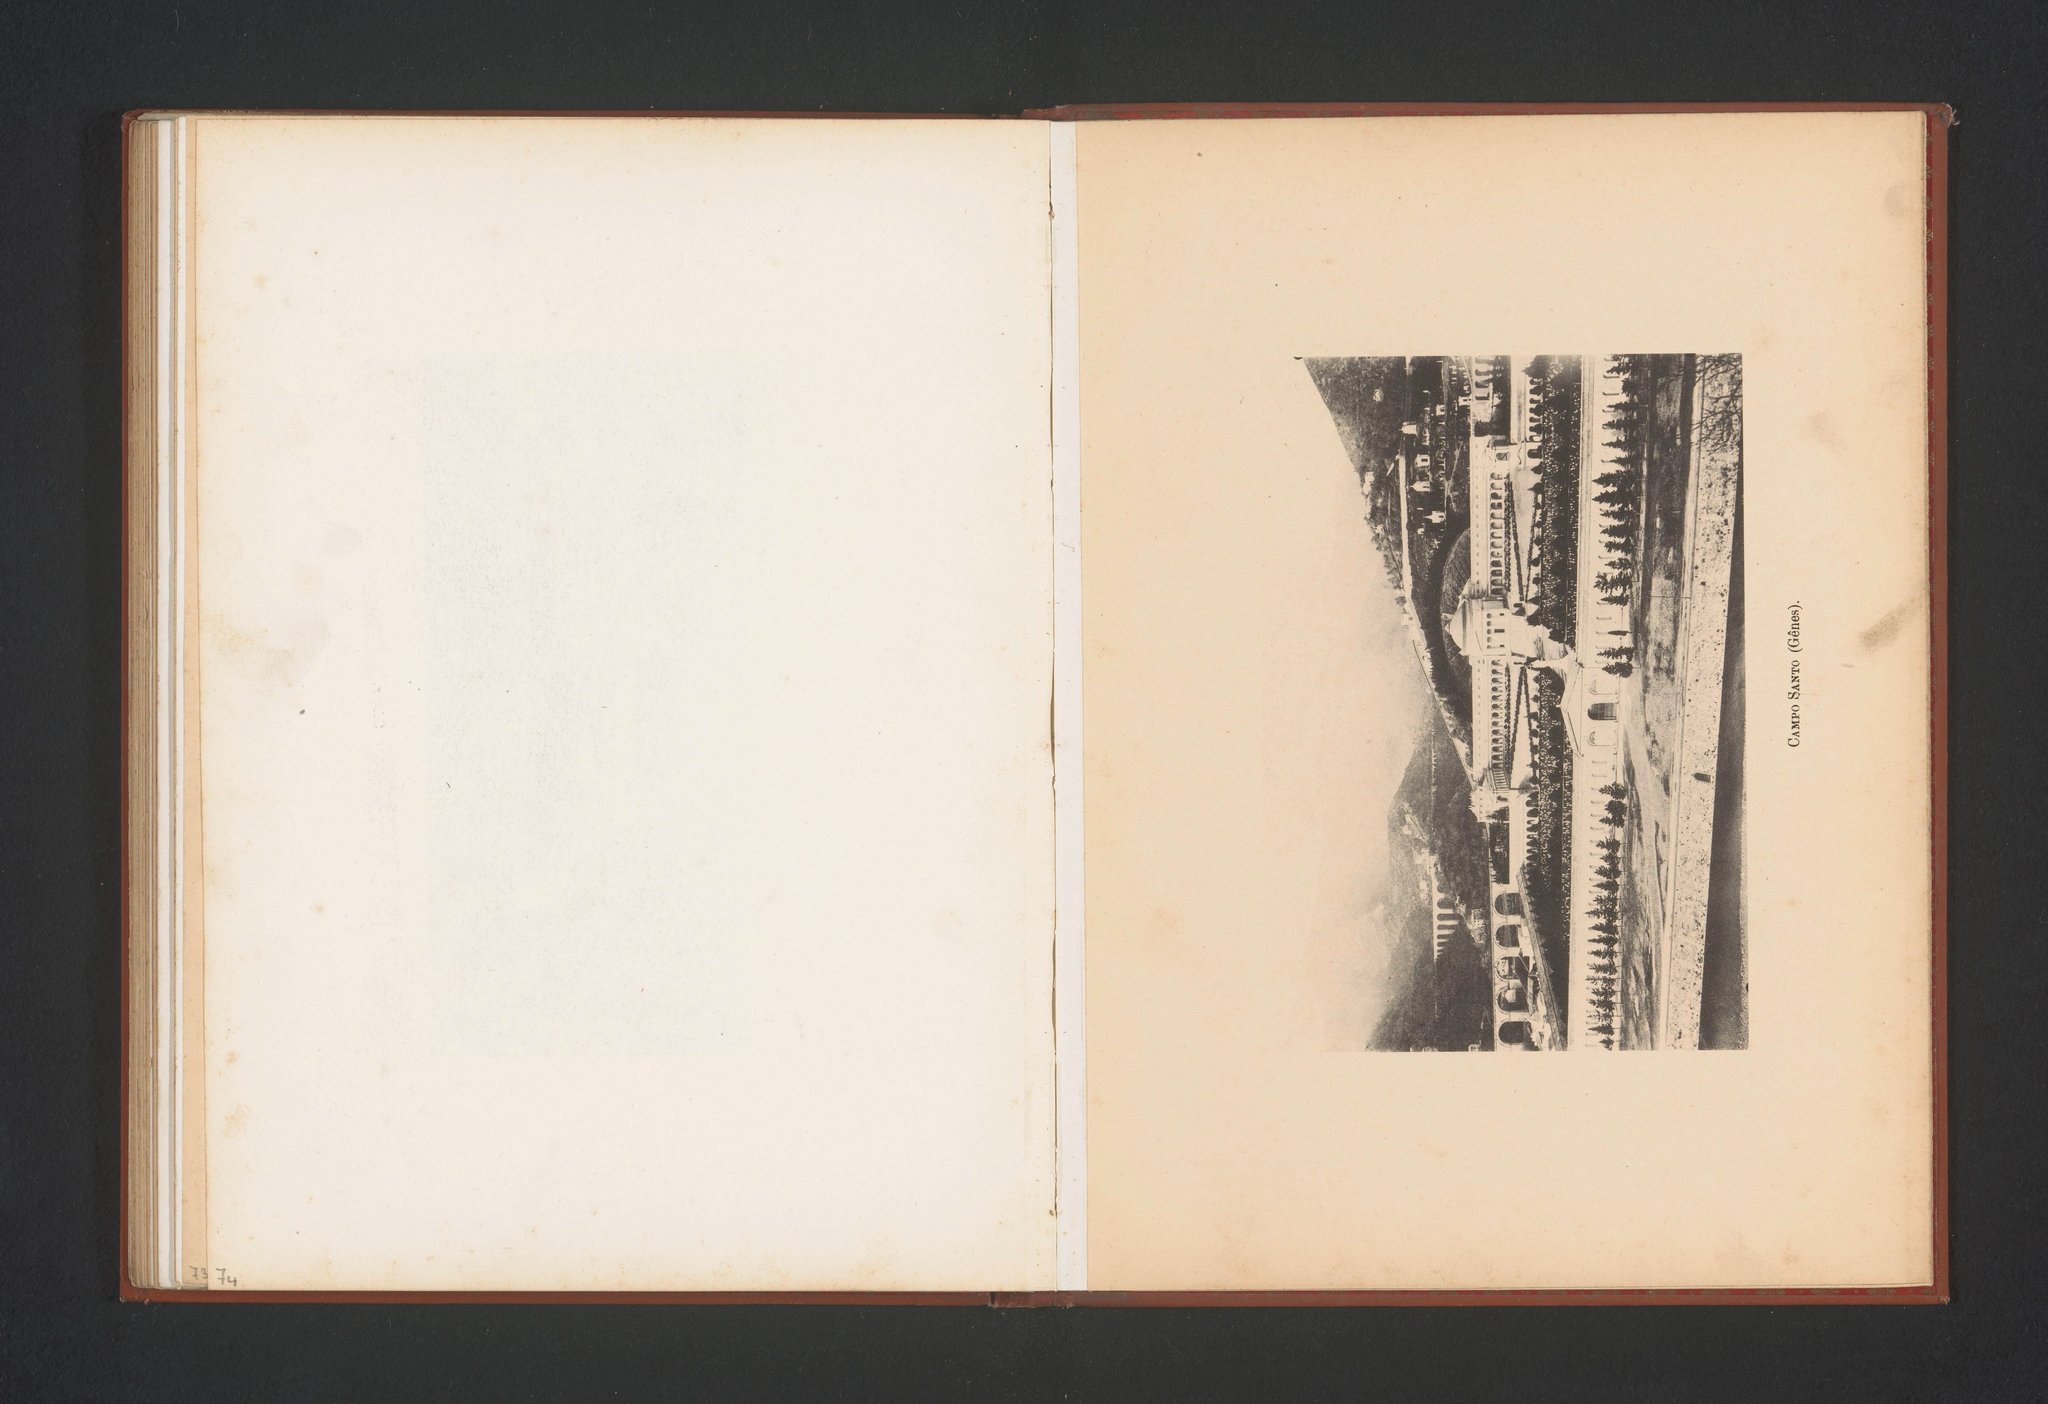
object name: page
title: Gezicht op de begraafplaats Campo Santo in Genua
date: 1880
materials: paper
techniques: photograph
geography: genoa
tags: churchyard, cemetery